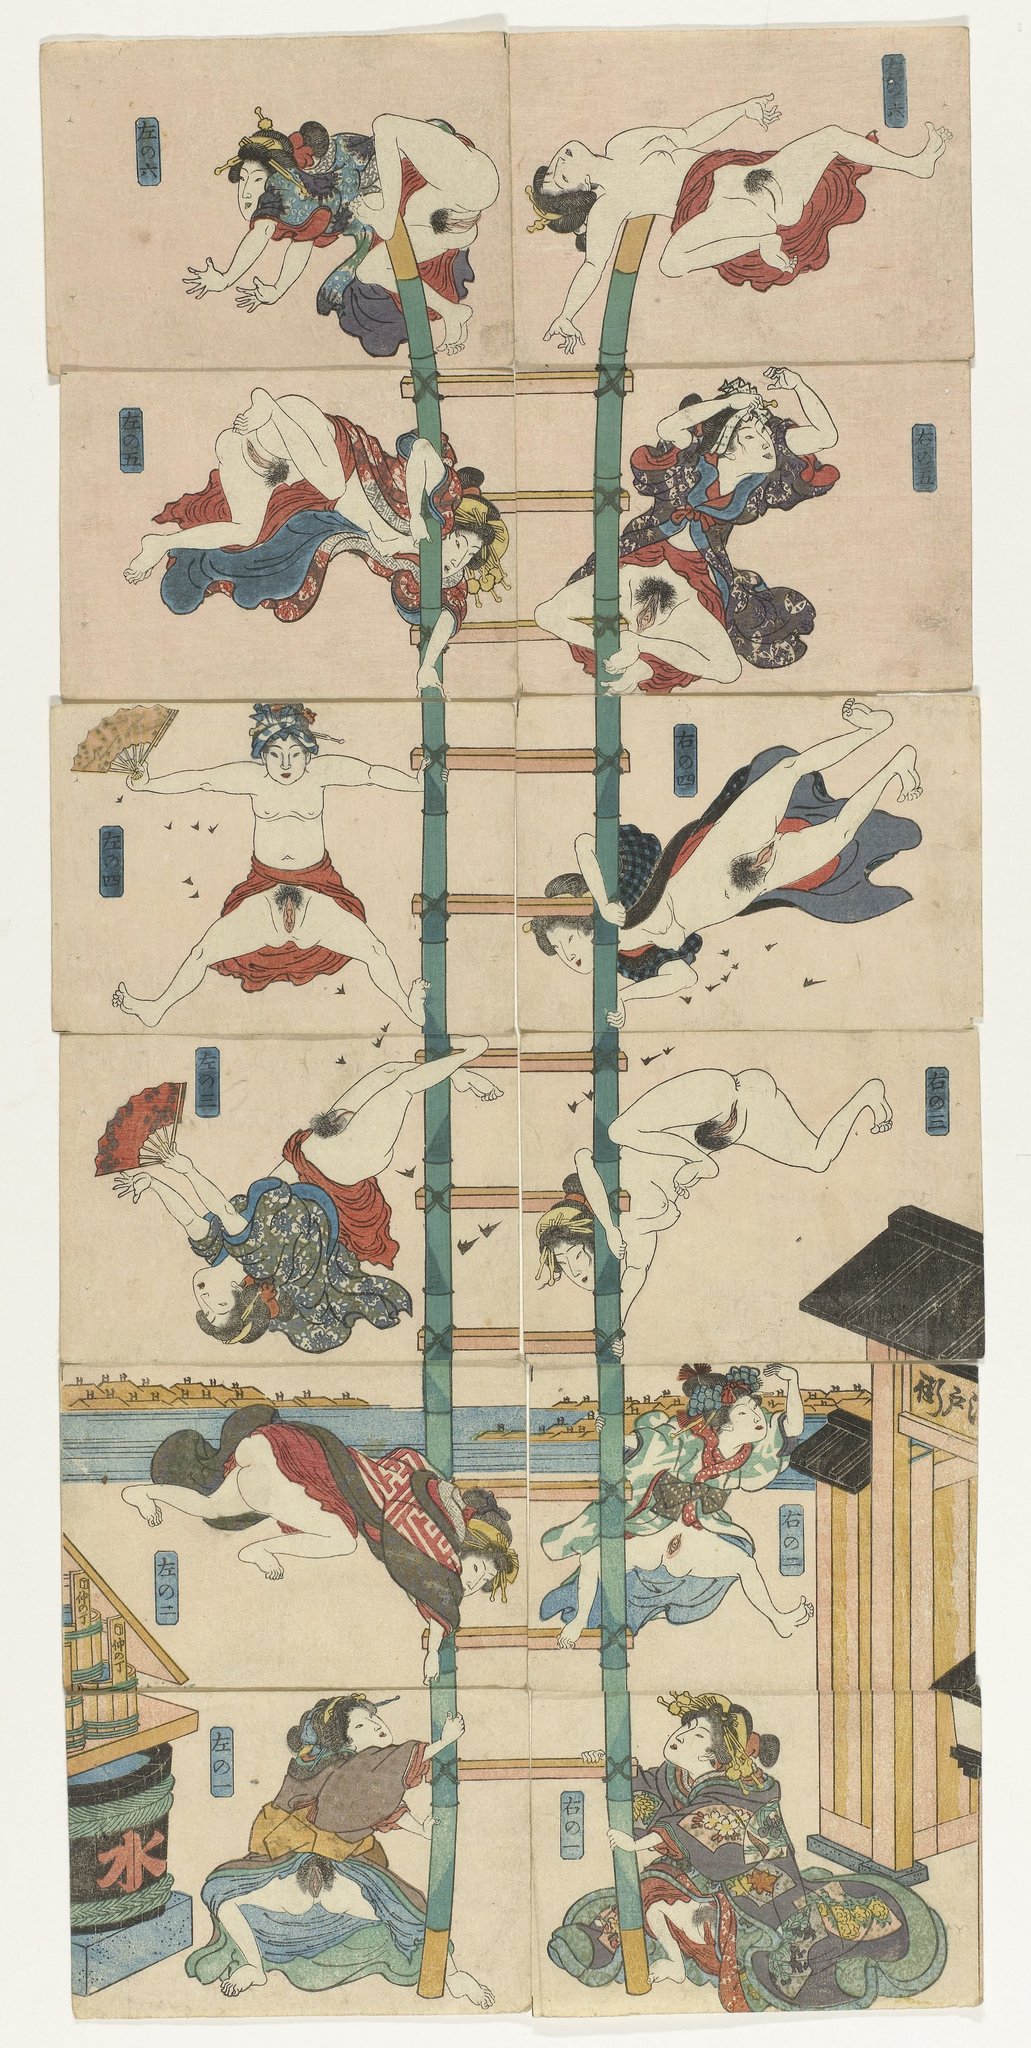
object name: print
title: Serie van twaalf koban Shunga met prostituées in de rol van acrobatische brandweerlieden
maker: utagawa kuniyoshi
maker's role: draughtsman, print maker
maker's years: 1798-1861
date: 1830-1835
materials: paper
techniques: woodcut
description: Serie van twaalf koban prenten met twaalf halfnaakte vrouwen die acrobatische toeren uithalen op een ladder. Per zes boven elkaar geplaatst vormen de twaalf genummerde bladen een parodie op soortgelijke voorstellingen van brandweerlieden die halsbrekende stunts uithalen. De opschriften op de emmers op de één na onderste prent links verwijzen naar de straat Nakanocho in het Yoshiwara district - de prostitutiewijk van Edo. Daaronder is het grote watervat weergegeven dat bij de poort van het Yoshiwara stond; de poort bevindt zich rechts. Mogelijk vormen de twaalf prentjes een kalender met verwijzingen naar de korte en lange maanden.